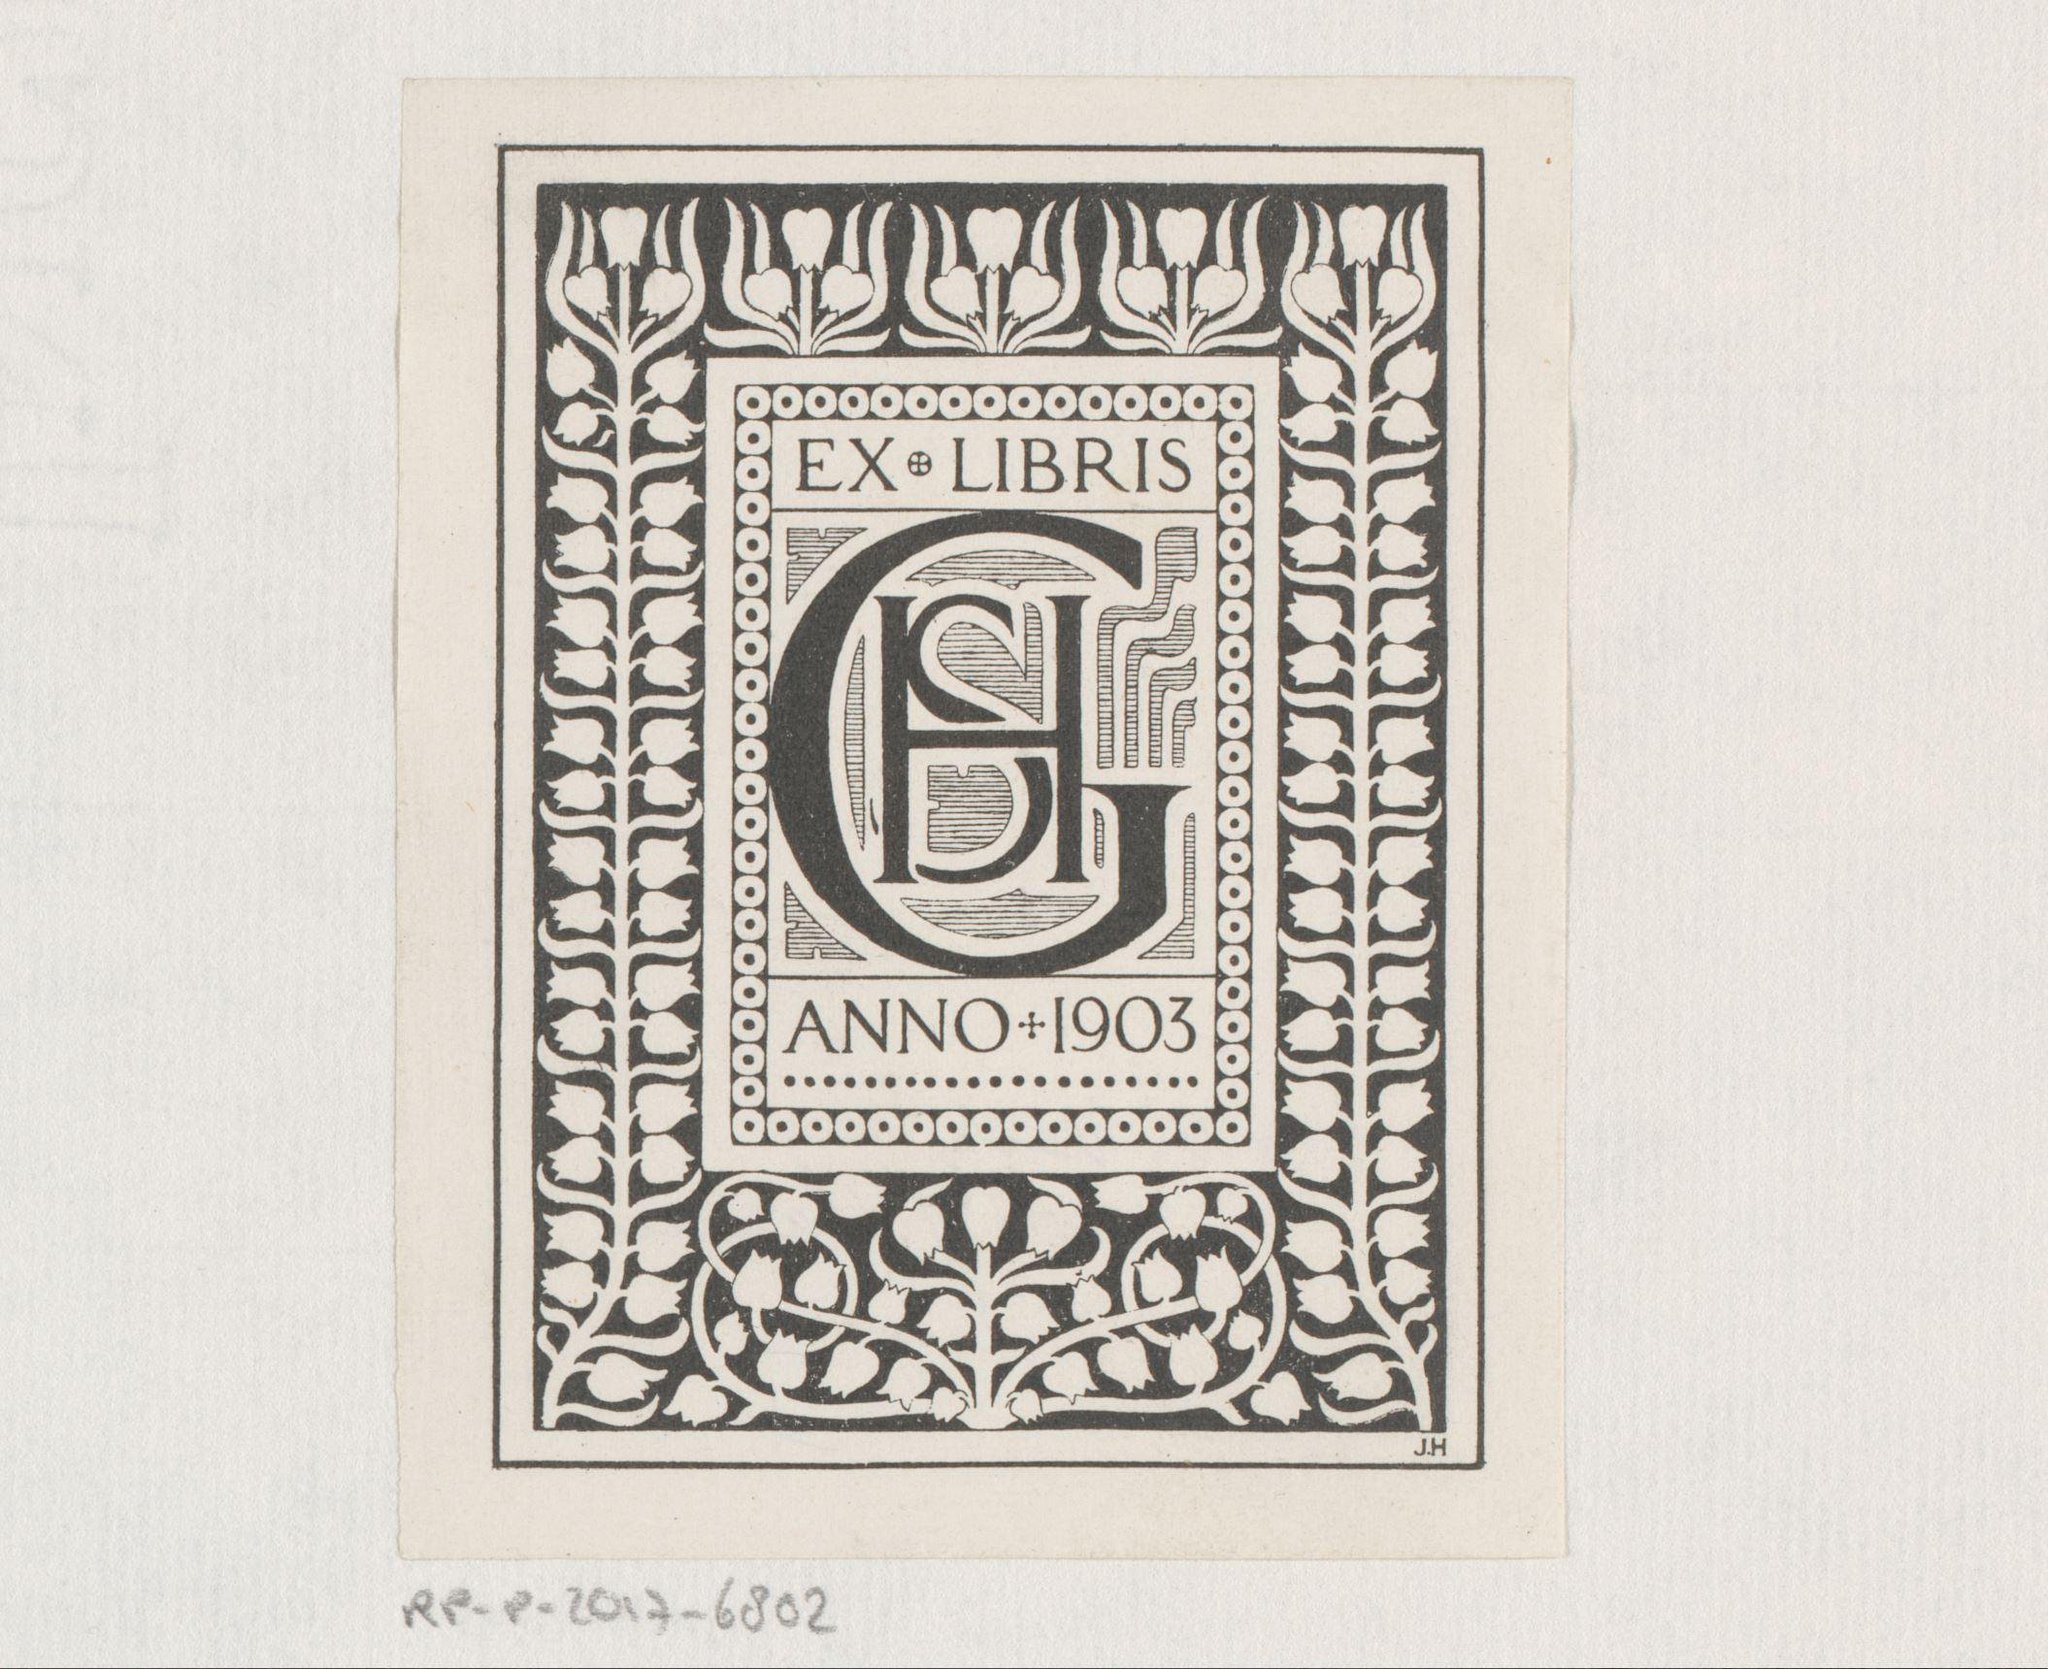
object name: bookplate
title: Ex libris van S.G.H.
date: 1903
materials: paper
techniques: printing block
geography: netherlands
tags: flowers ~ ornament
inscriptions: inscription: ‘S. Gorter-Hertz / door J. Hanau’